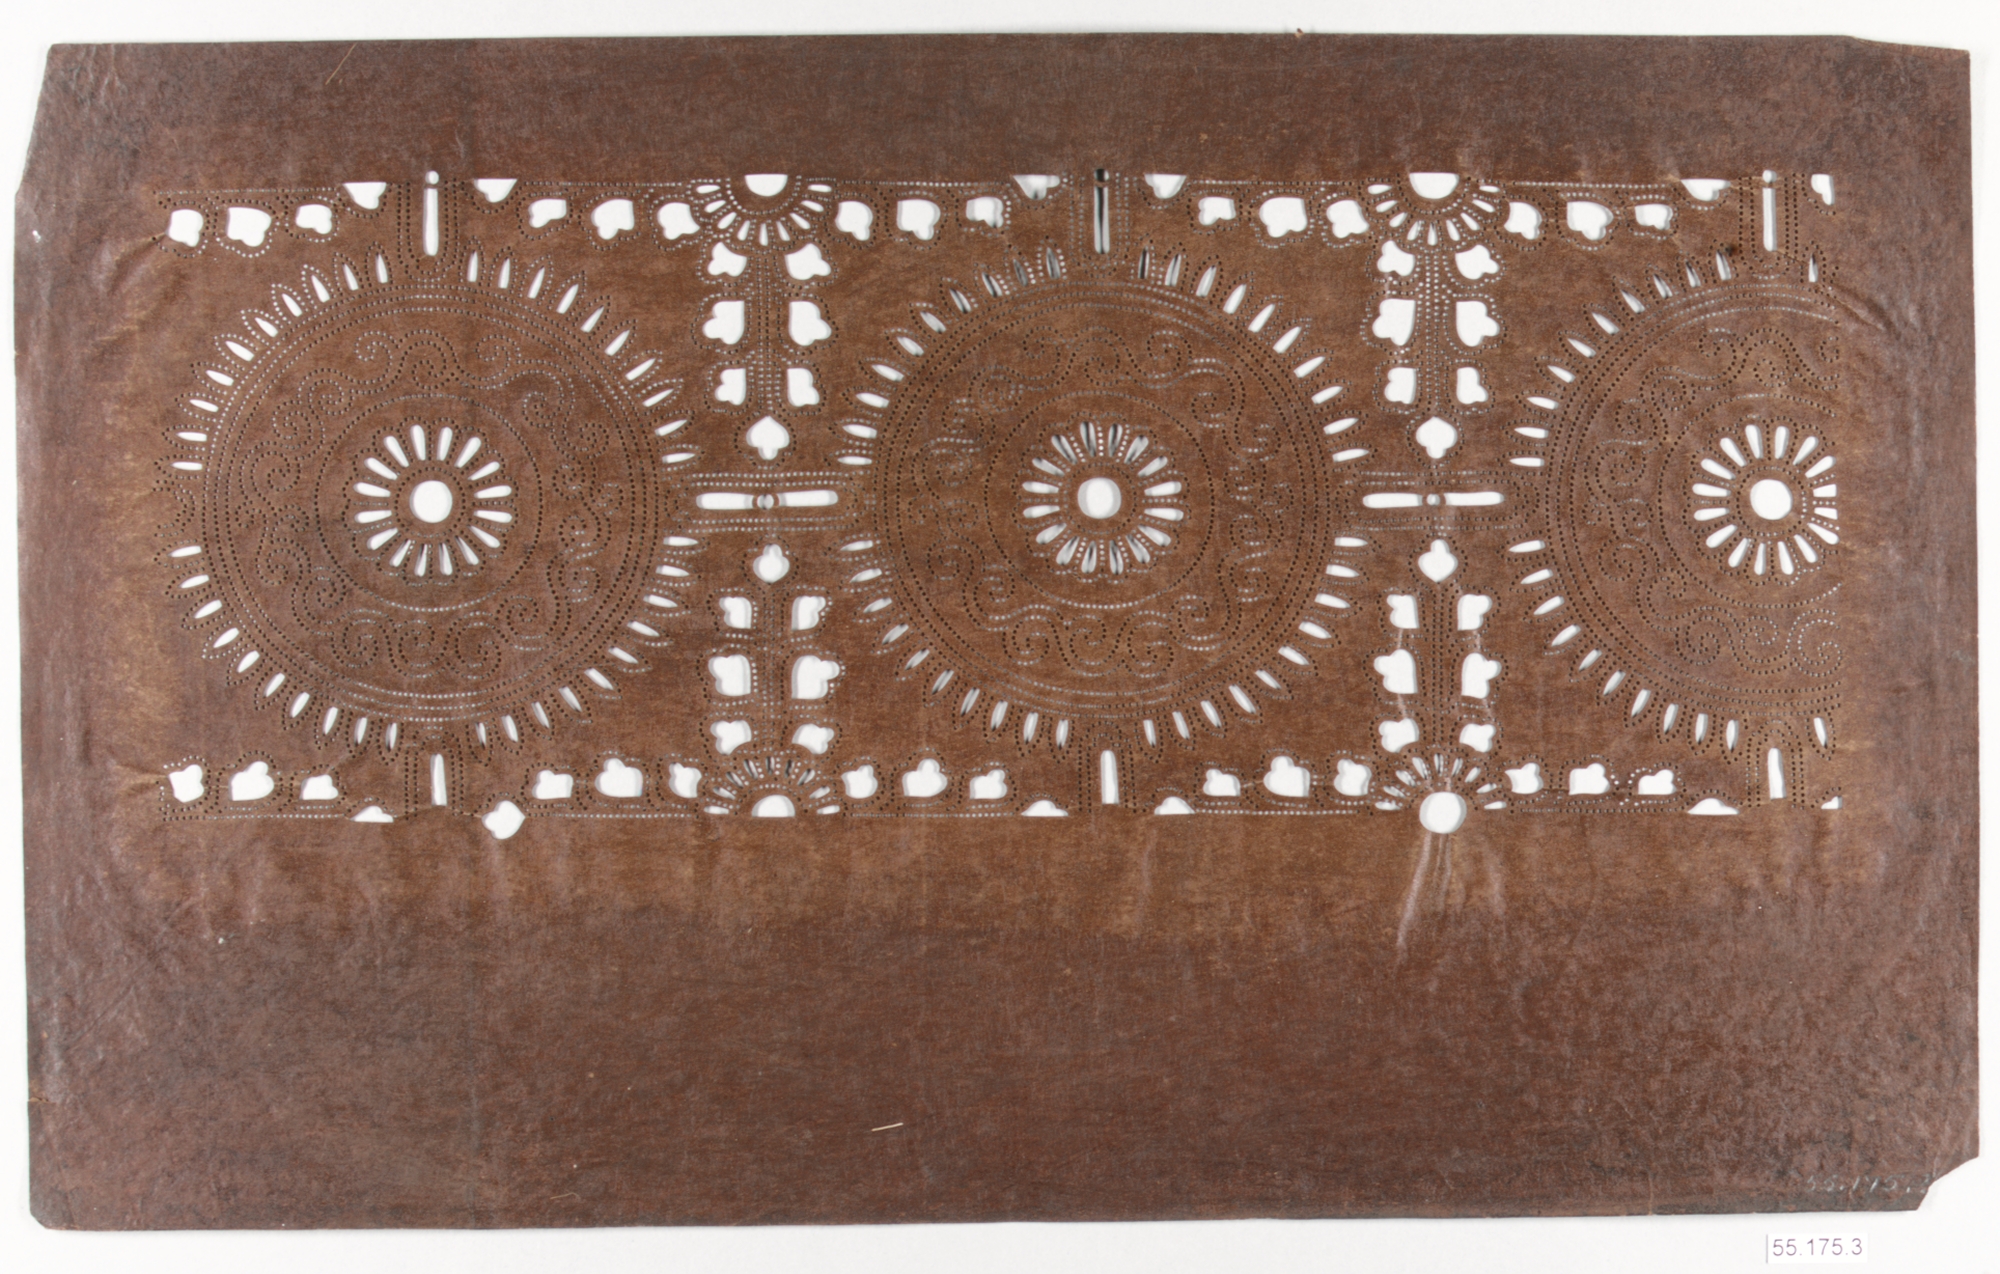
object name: stencil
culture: japanese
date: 1801-1900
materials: paper